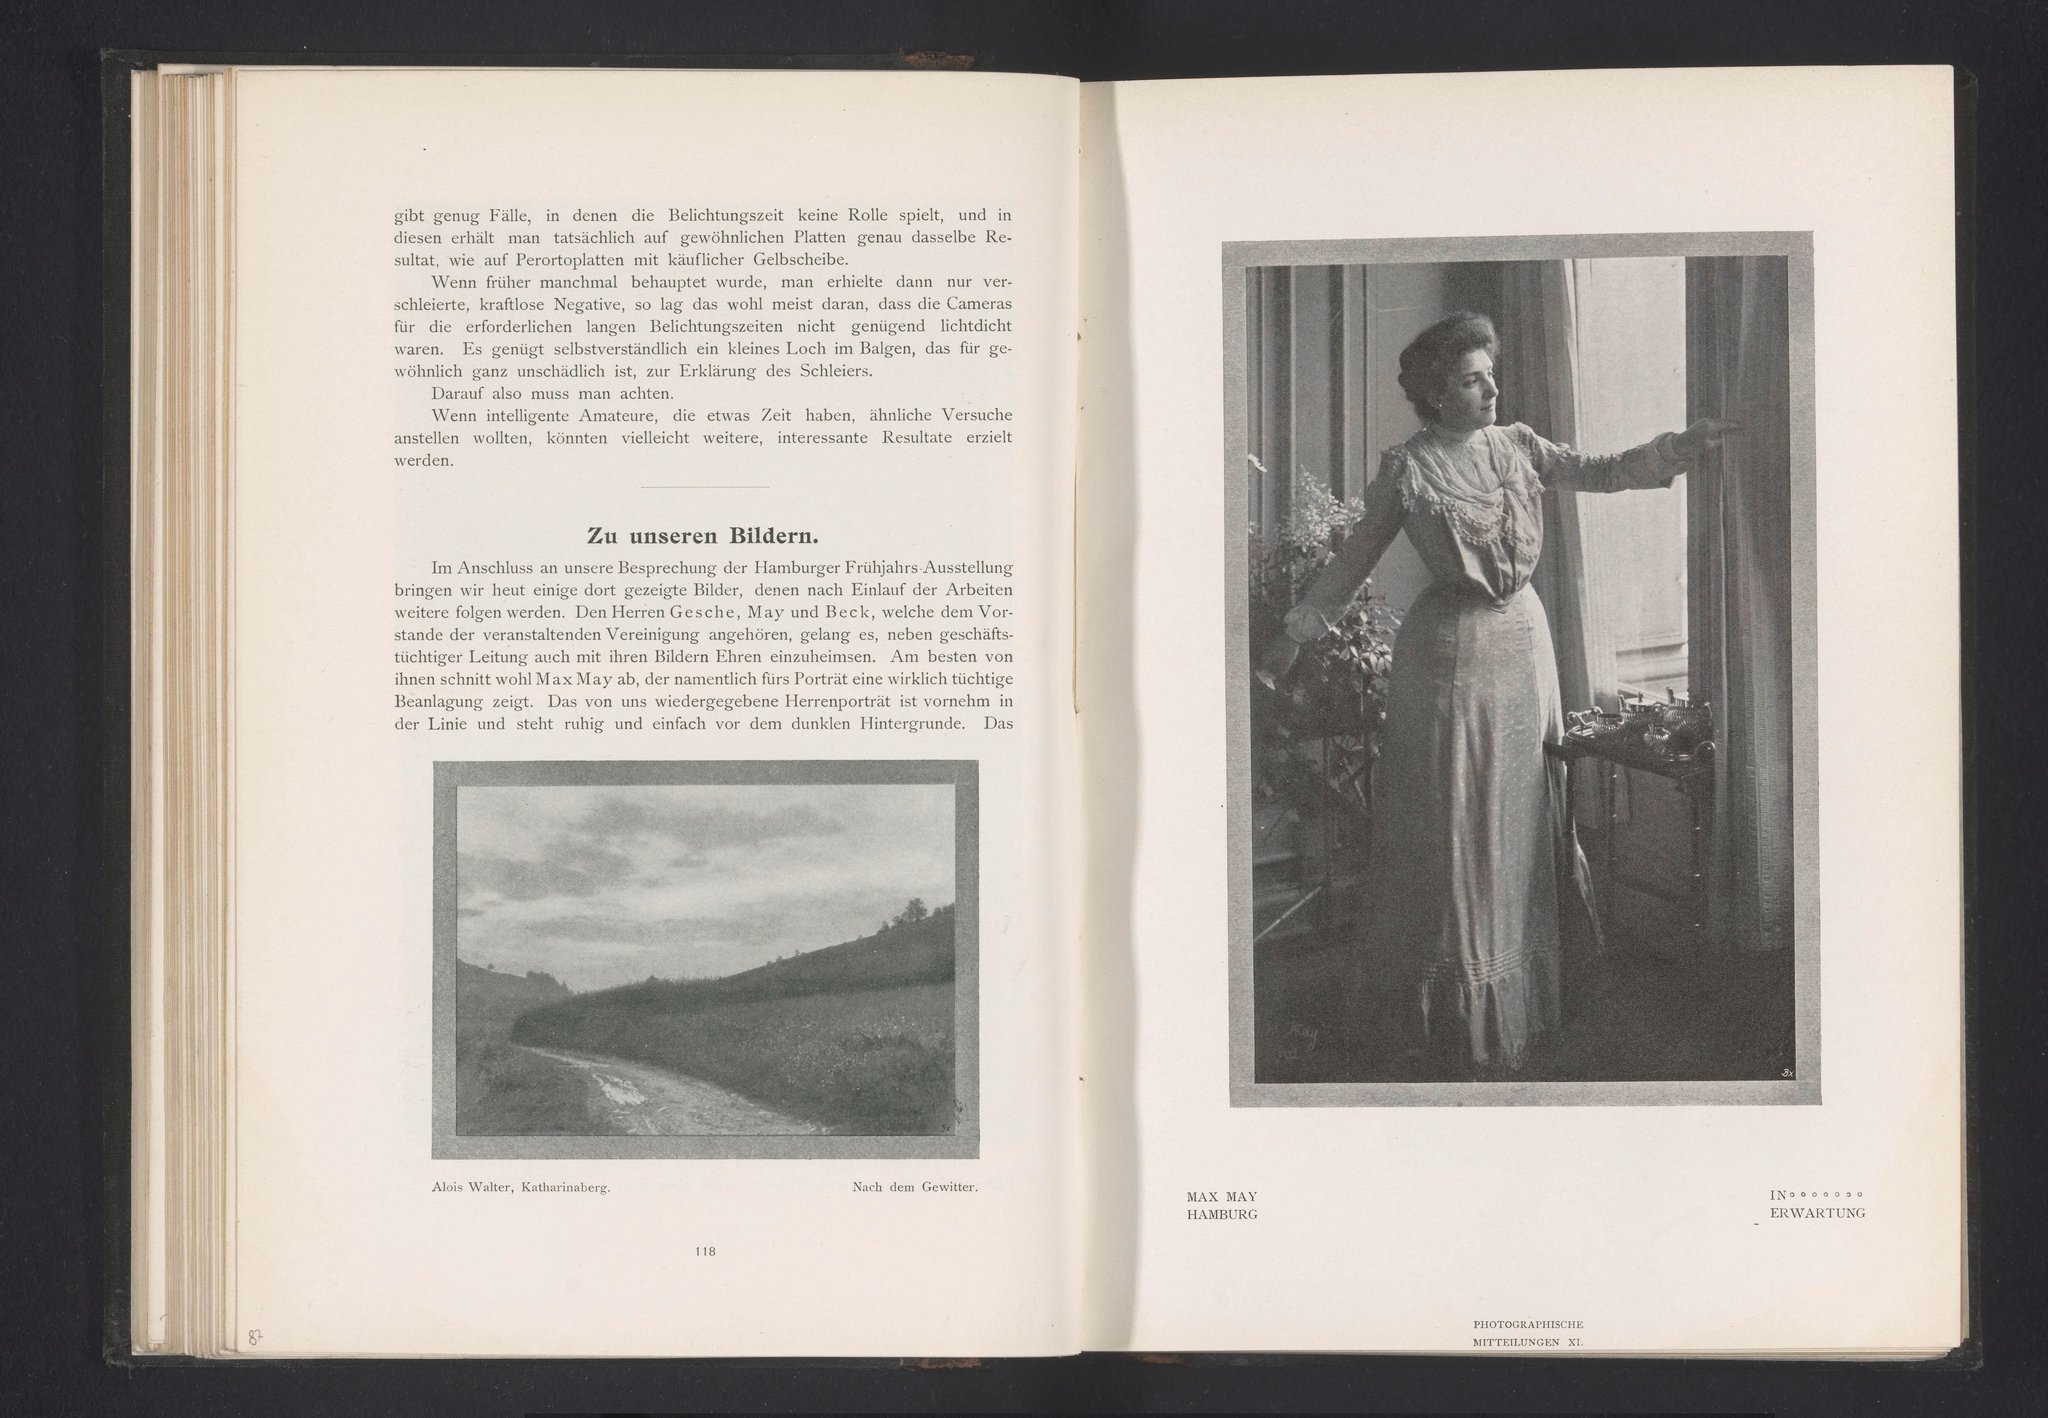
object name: page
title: Landschap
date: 1898-1903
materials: paper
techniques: autotype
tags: landscapes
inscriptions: monogram: ‘BX’, inscription: ‘Katharinaberg’